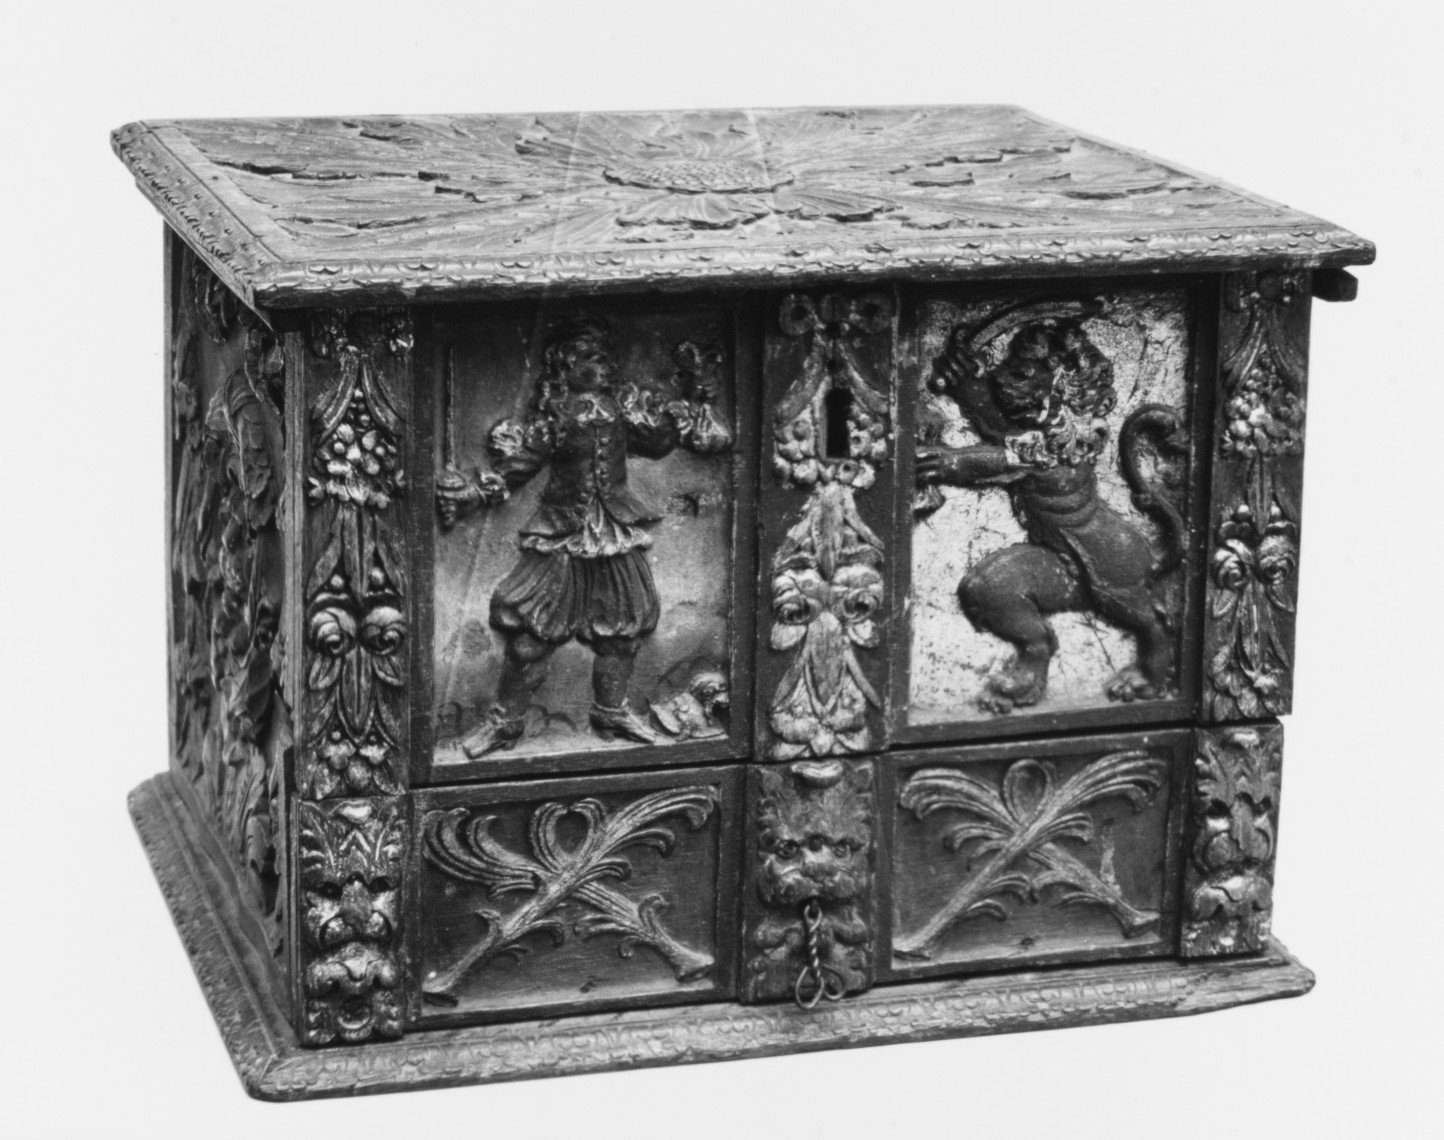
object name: box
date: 1601-1700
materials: wood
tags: men,lions